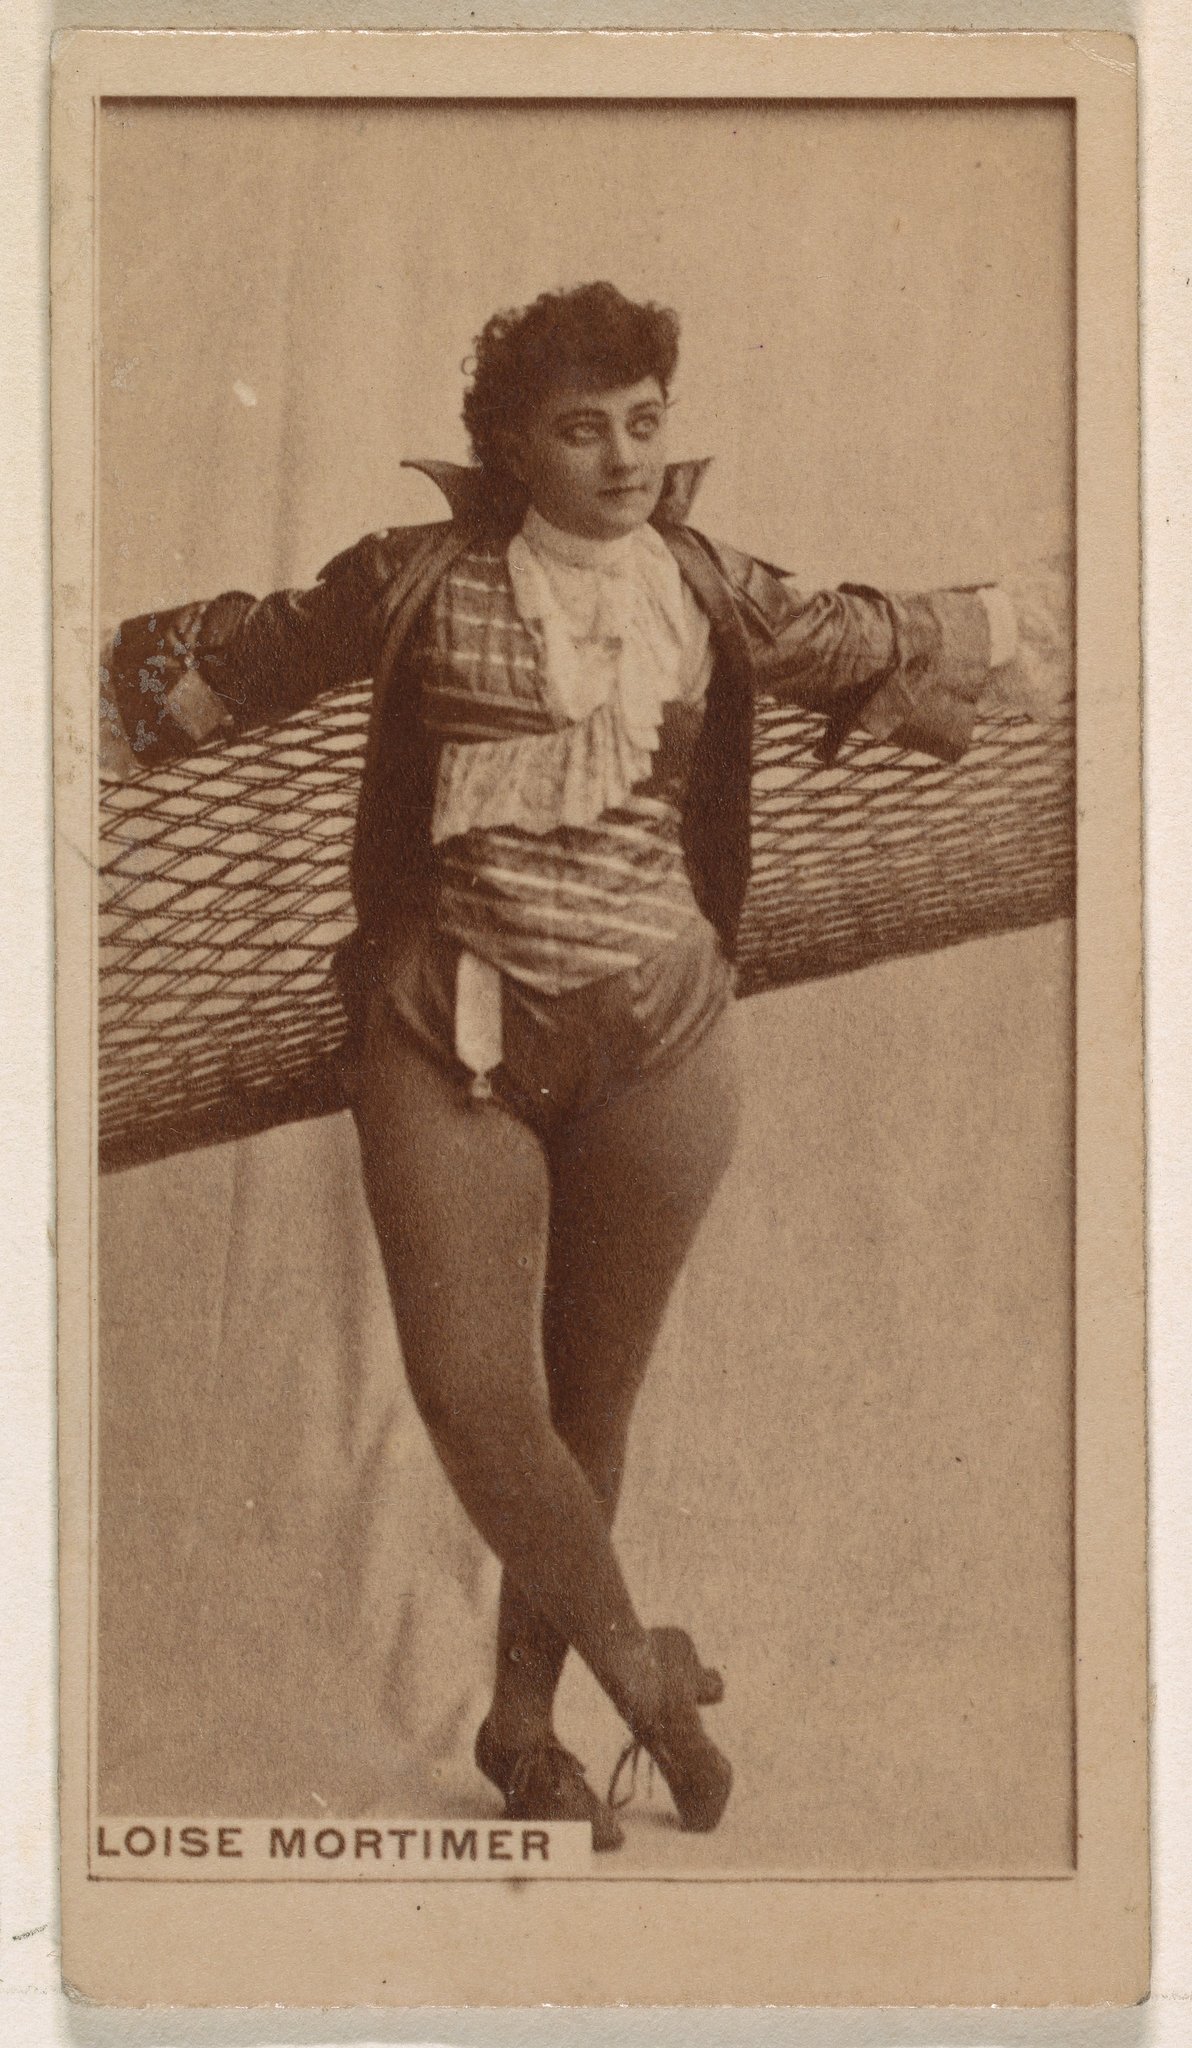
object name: photograph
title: Loise Mortimer, from the Actresses series (N245) issued by Kinney Brothers to promote Sweet Caporal Cigarettes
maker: kinney brothers tobacco company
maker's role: publisher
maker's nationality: american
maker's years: 1869-2011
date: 1890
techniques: albumen silver print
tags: portraits,women,actresses